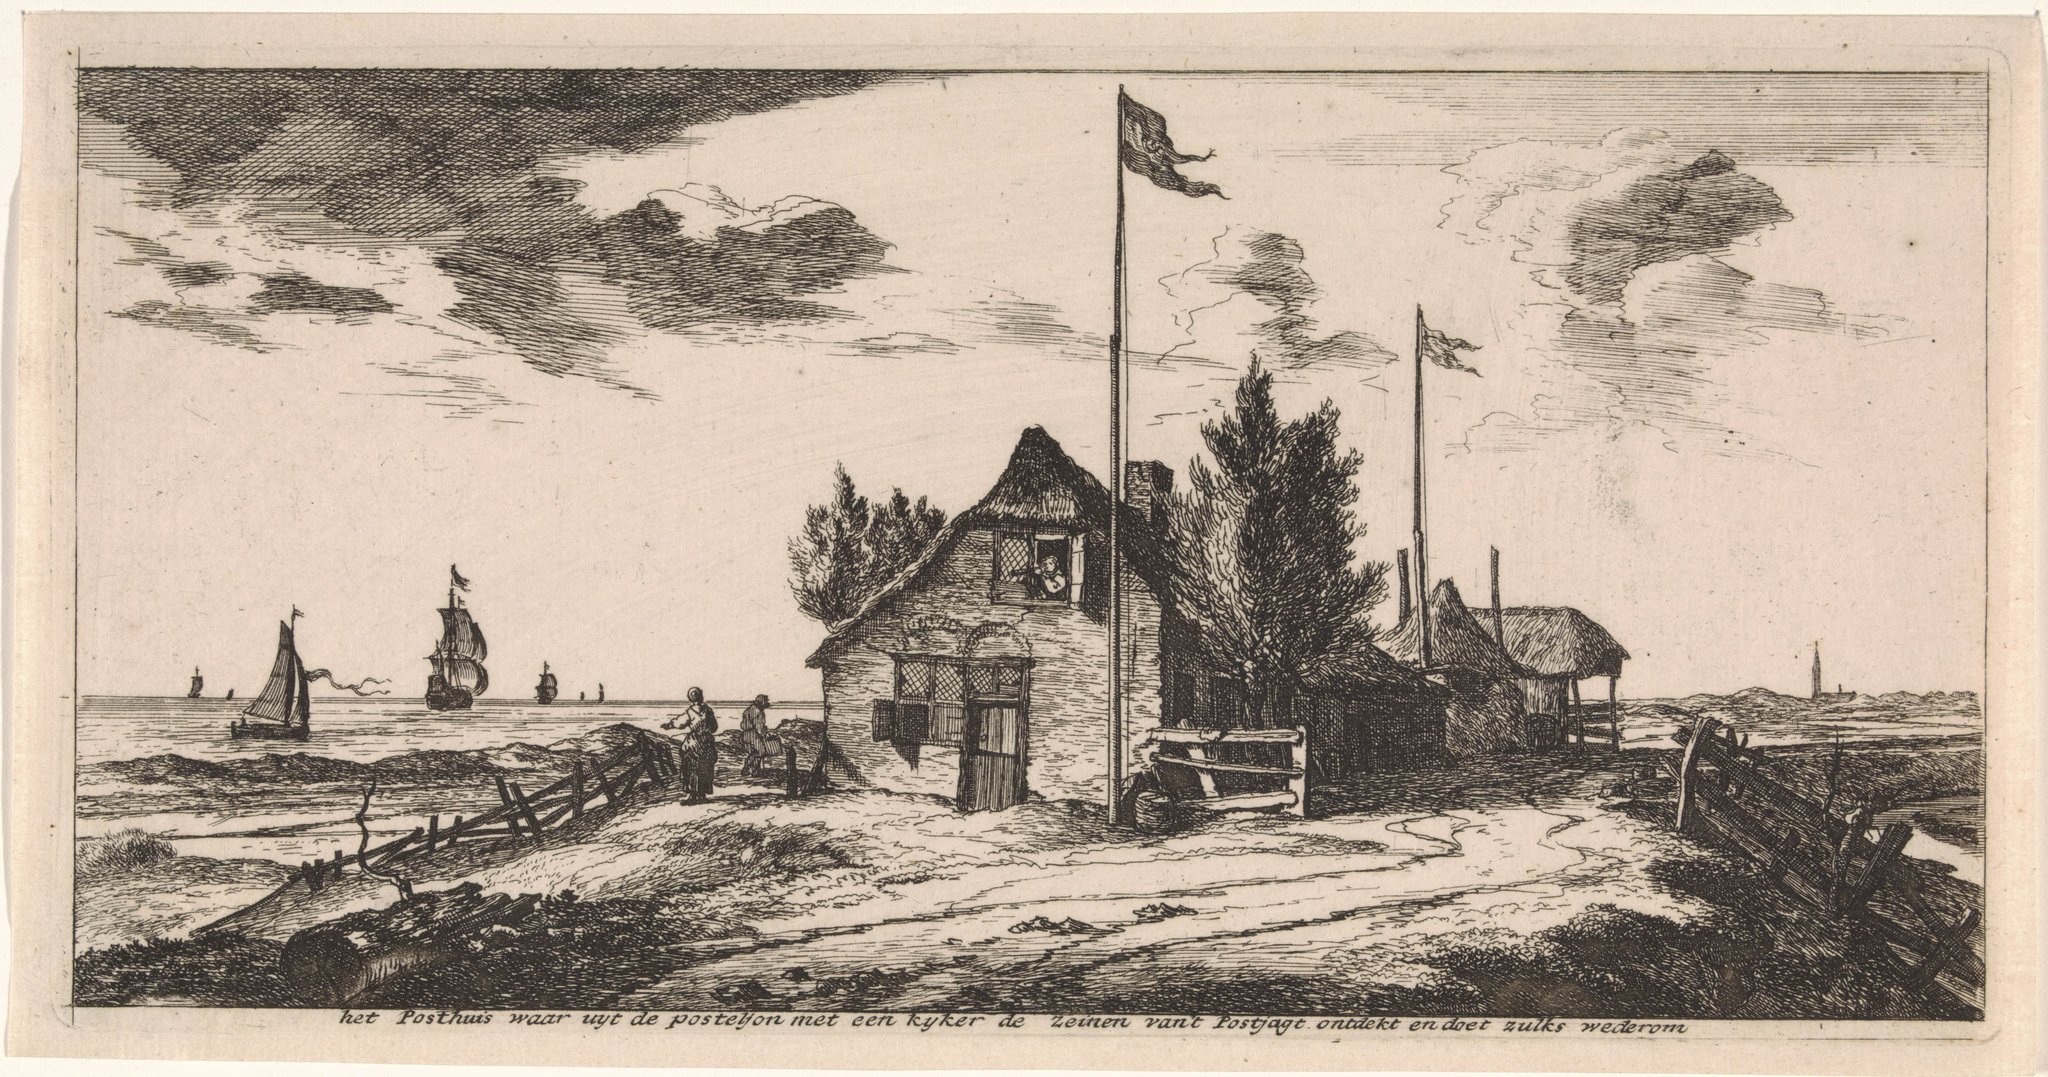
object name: print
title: Posthuis met een postbode op uitkijk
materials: paper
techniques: engraving, etching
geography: rotterdam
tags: postal service, sending, packing of postal matter, rowing-boat, canoe, etc., sea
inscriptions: collector's mark: Lugt 2228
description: Een posthuis aan de oever van een rivier. Op de bovenste verdieping staat een postbode op de uitkijk naar schepen. Hij tuurt met een verrekijker uit het venster. De prent heeft een Nederlands onderschrift met uitleg.